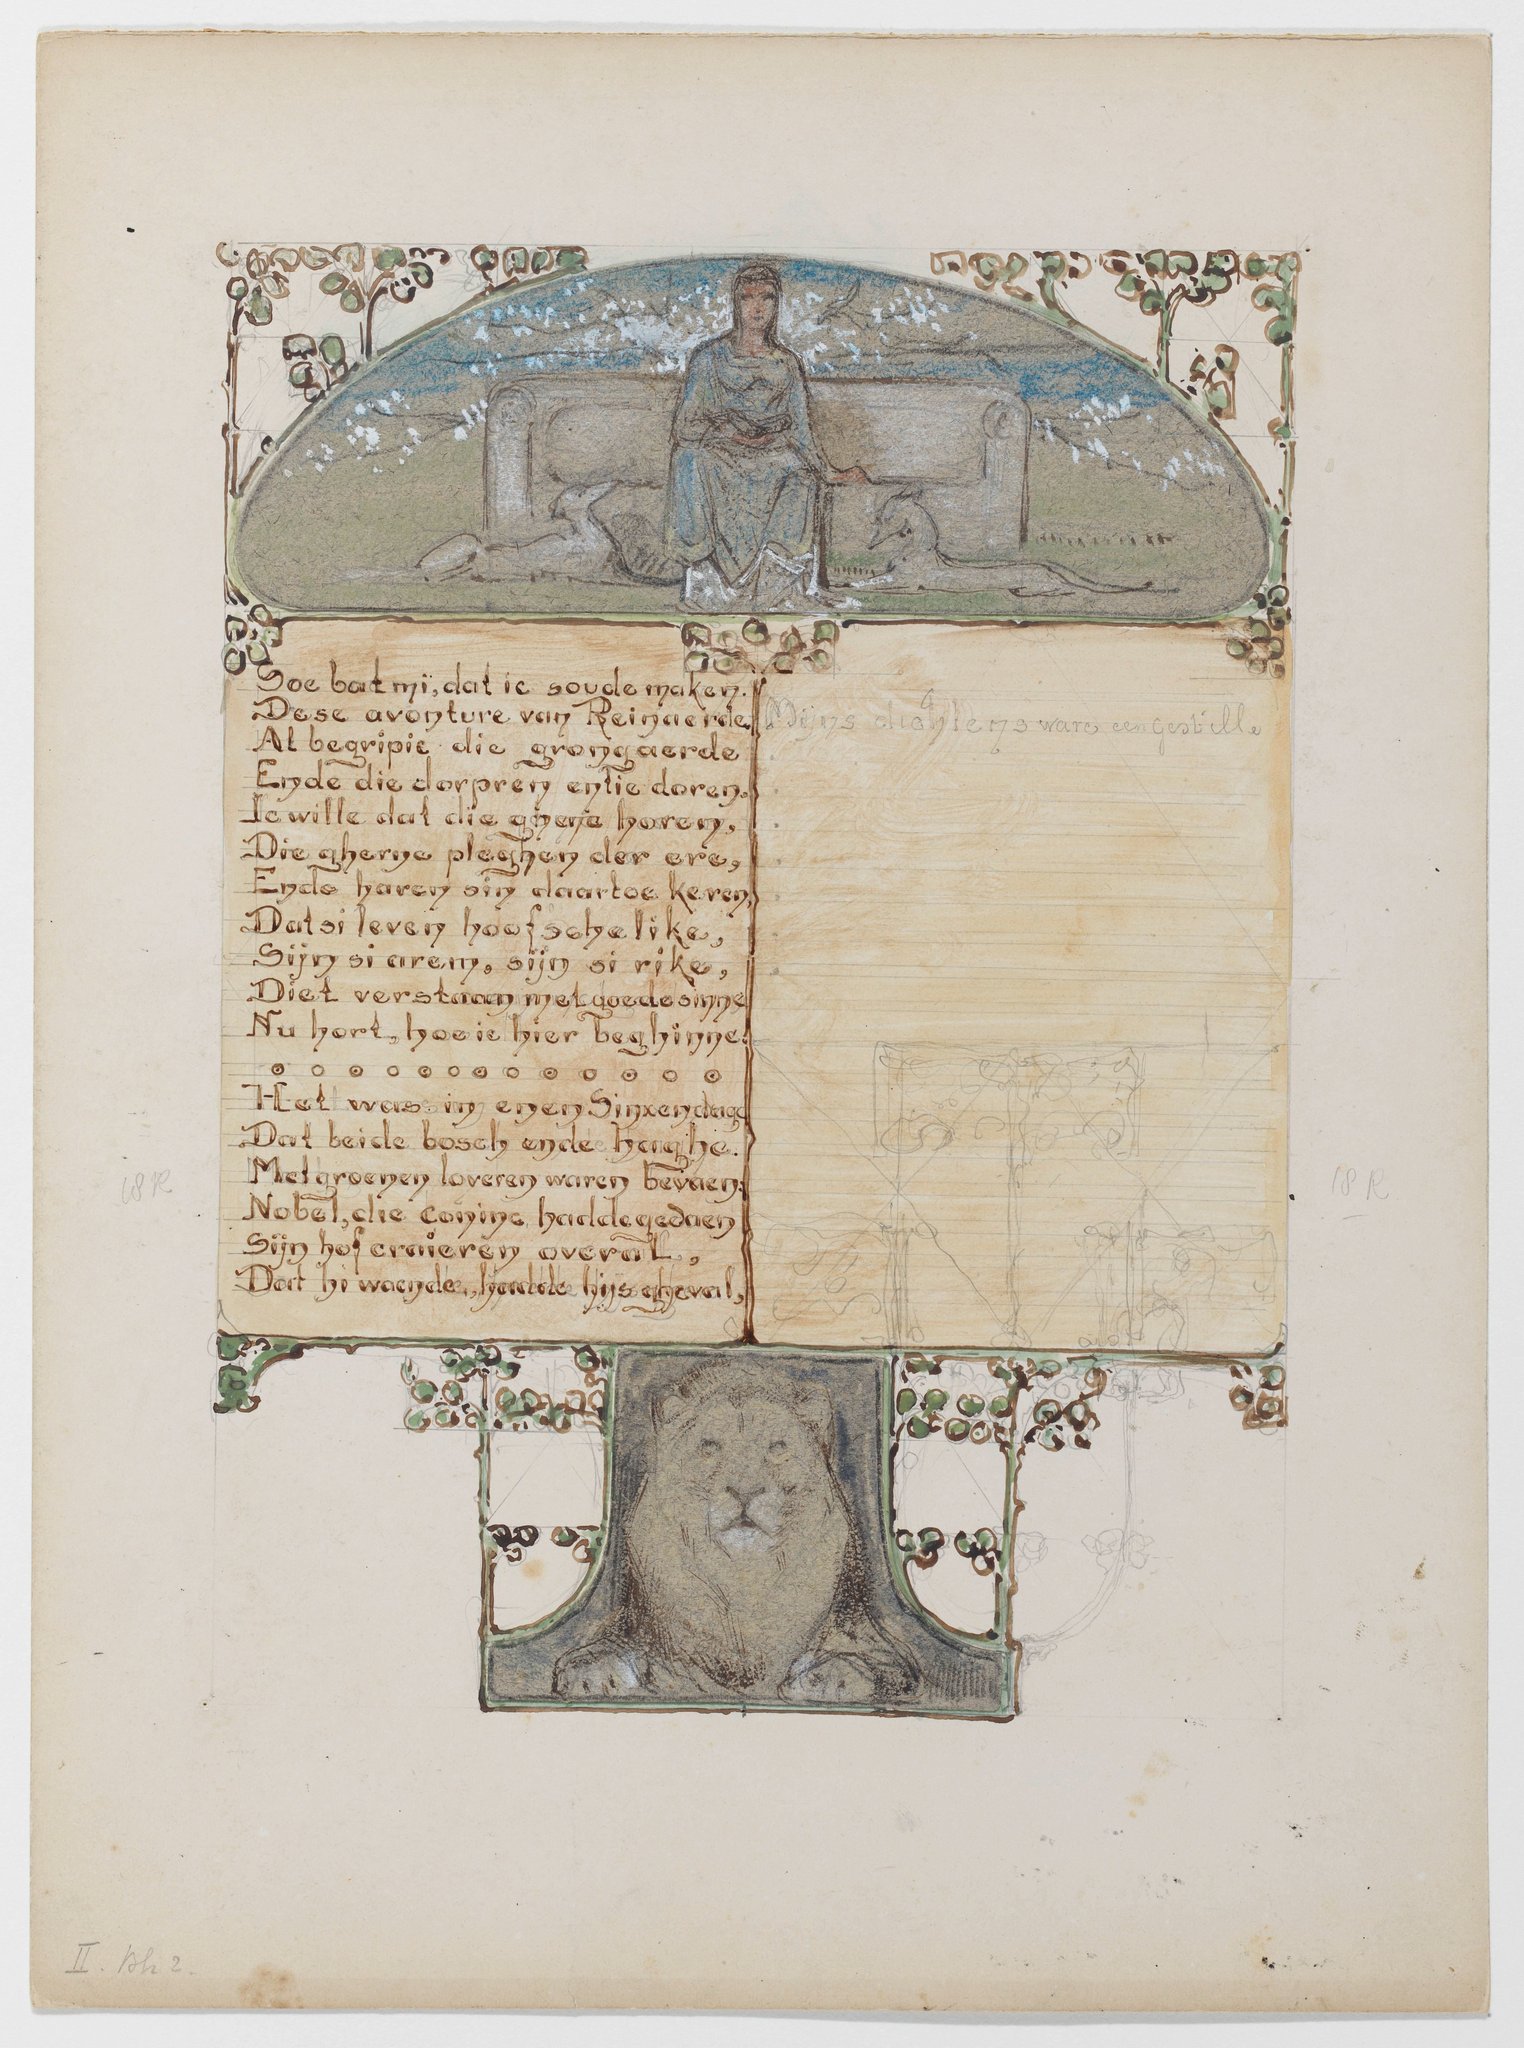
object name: drawing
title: Vrouw op een bank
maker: bernard willem wierink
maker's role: draughtsman, print maker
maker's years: 1856-1939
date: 1866-1939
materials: cardboard, chalk, ink, paper, pencil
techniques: brush, pen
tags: fable of reynard the fox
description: Ontwerp voor illustratie (fol. 2): Van den Vos Reinaerde; Vrouw op een bank.